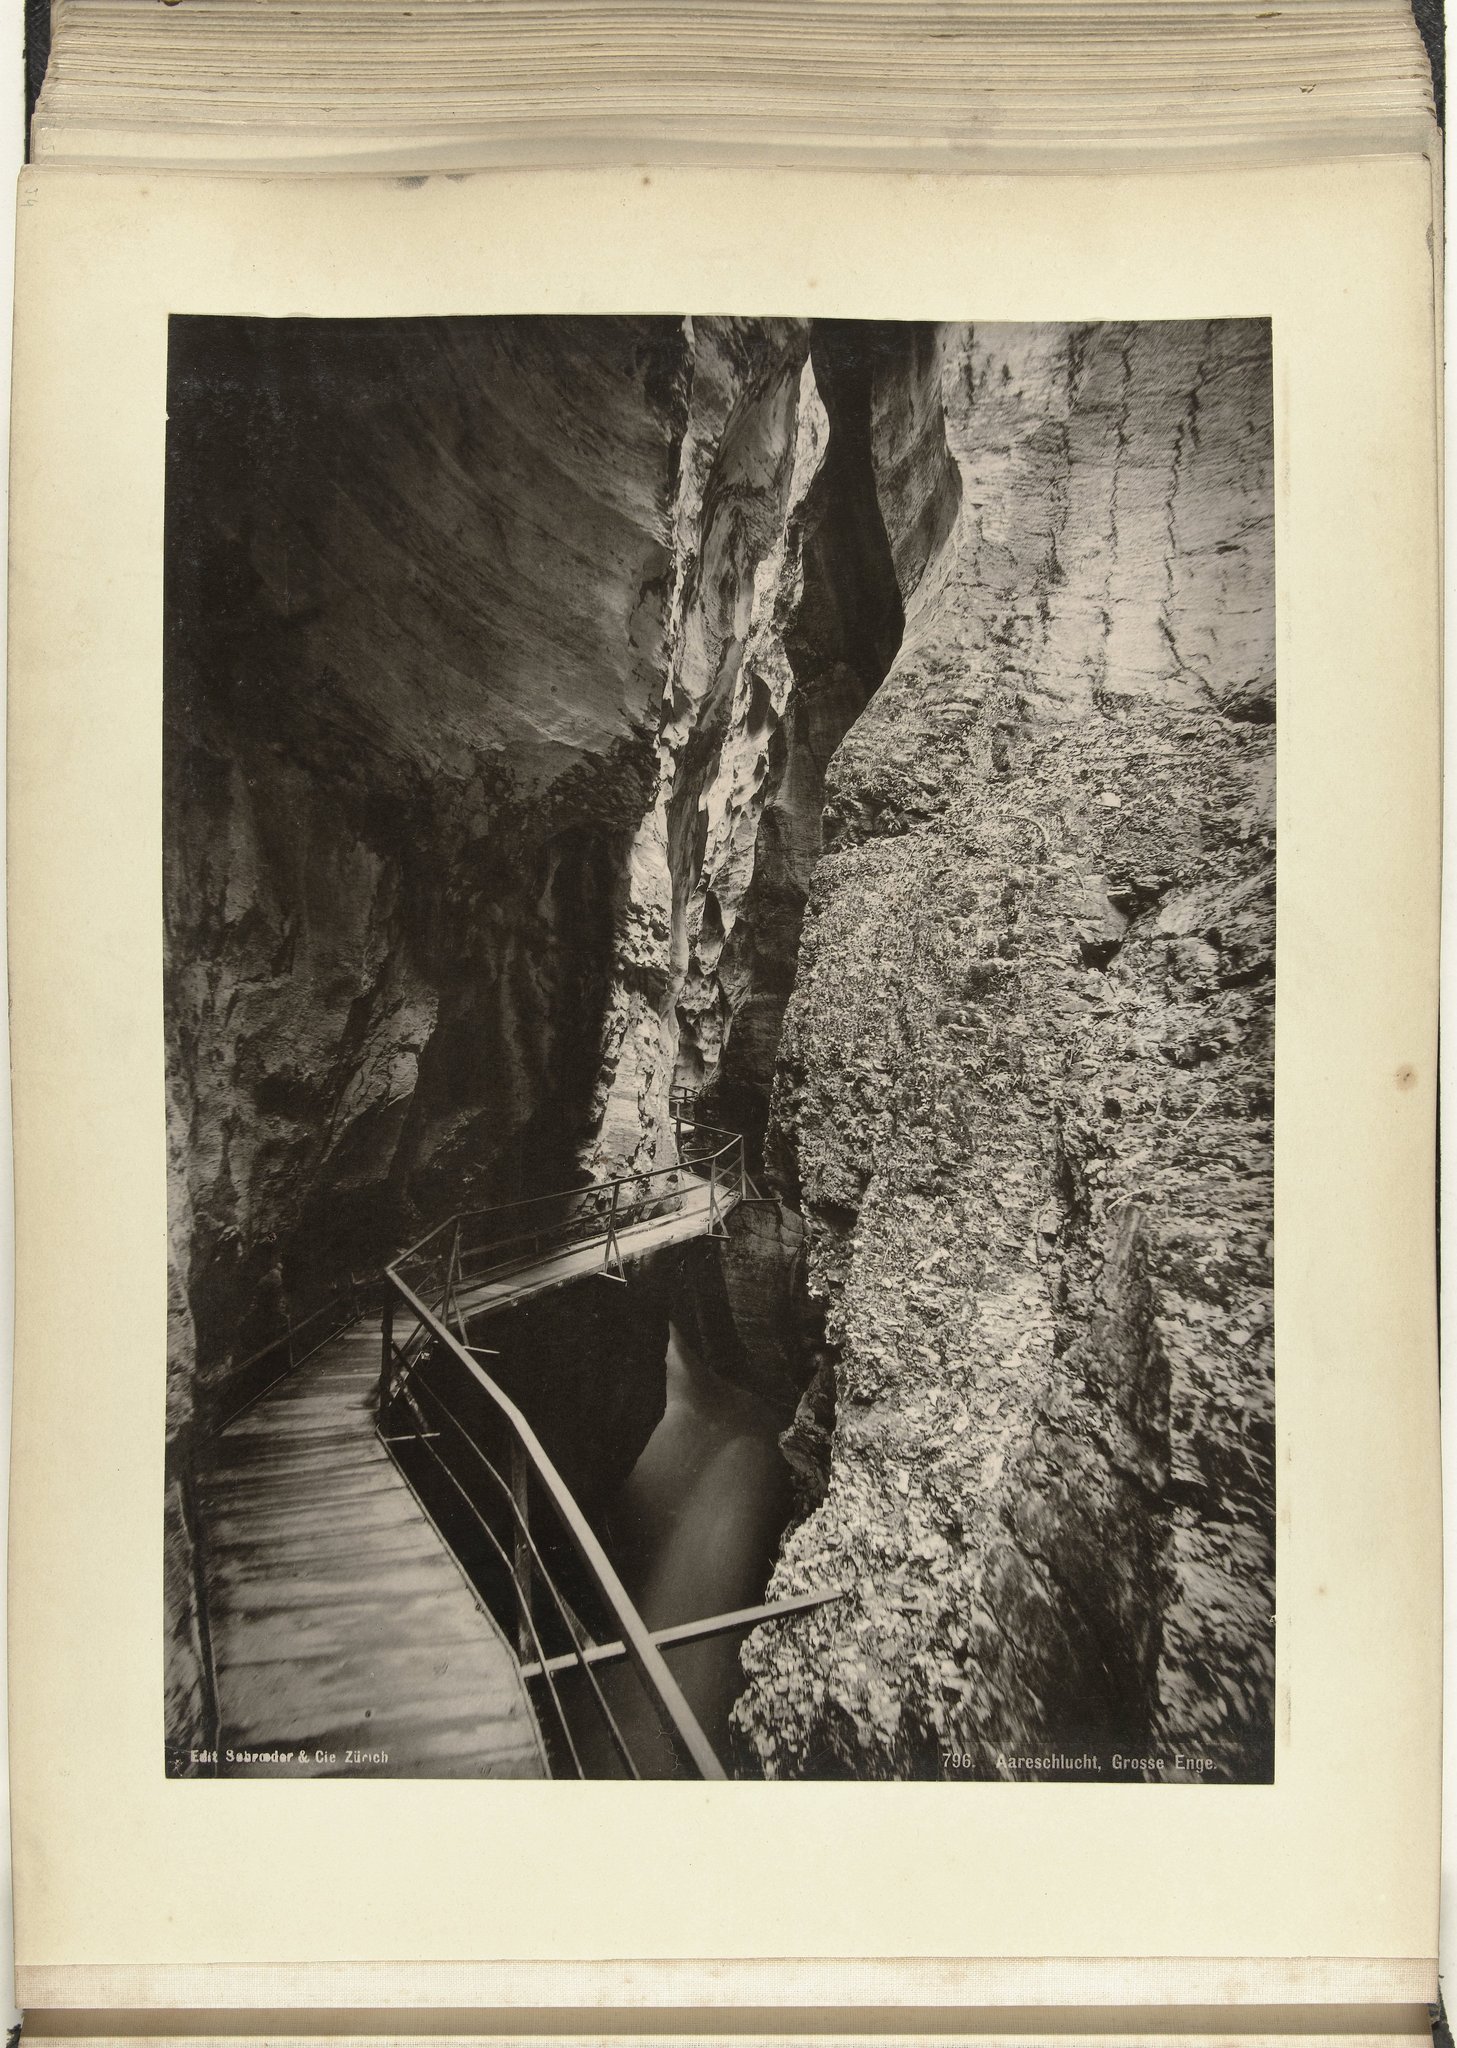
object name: photomechanical print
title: Aareschlucht, Grosse Enge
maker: Anonymous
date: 1881-1895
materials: paper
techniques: photograph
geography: zurich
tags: ravine, chasm, abyss, canyon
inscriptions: number: ‘796.’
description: Deze prent maakt deel uit van een album.